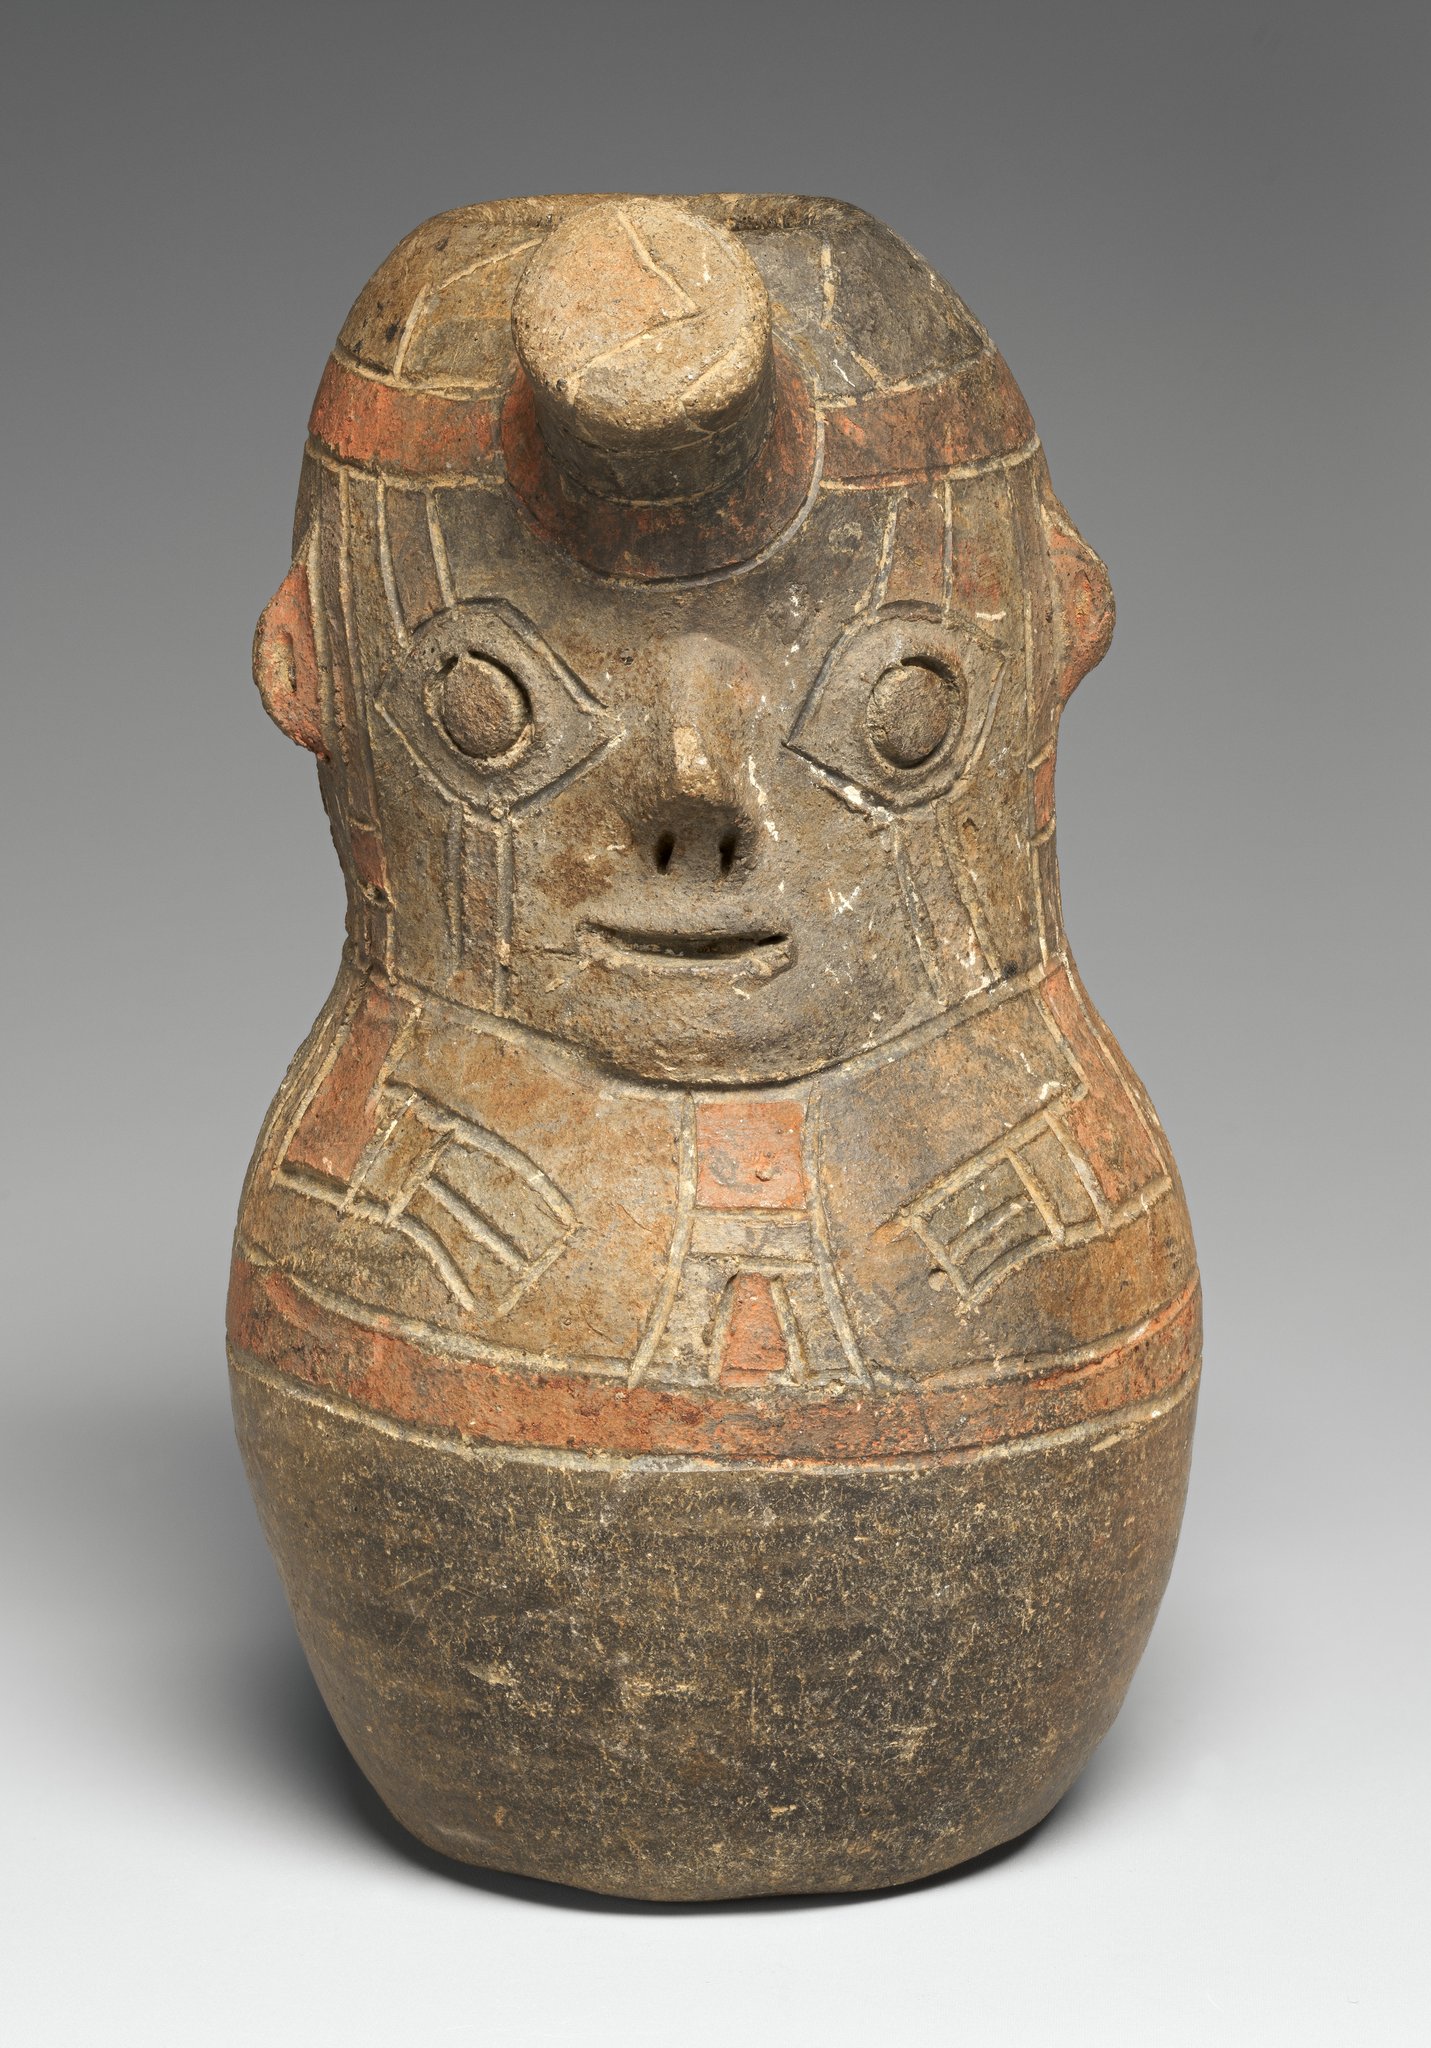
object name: bottle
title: Figure Bottle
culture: paracas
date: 600-301 BCE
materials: ceramic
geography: peru